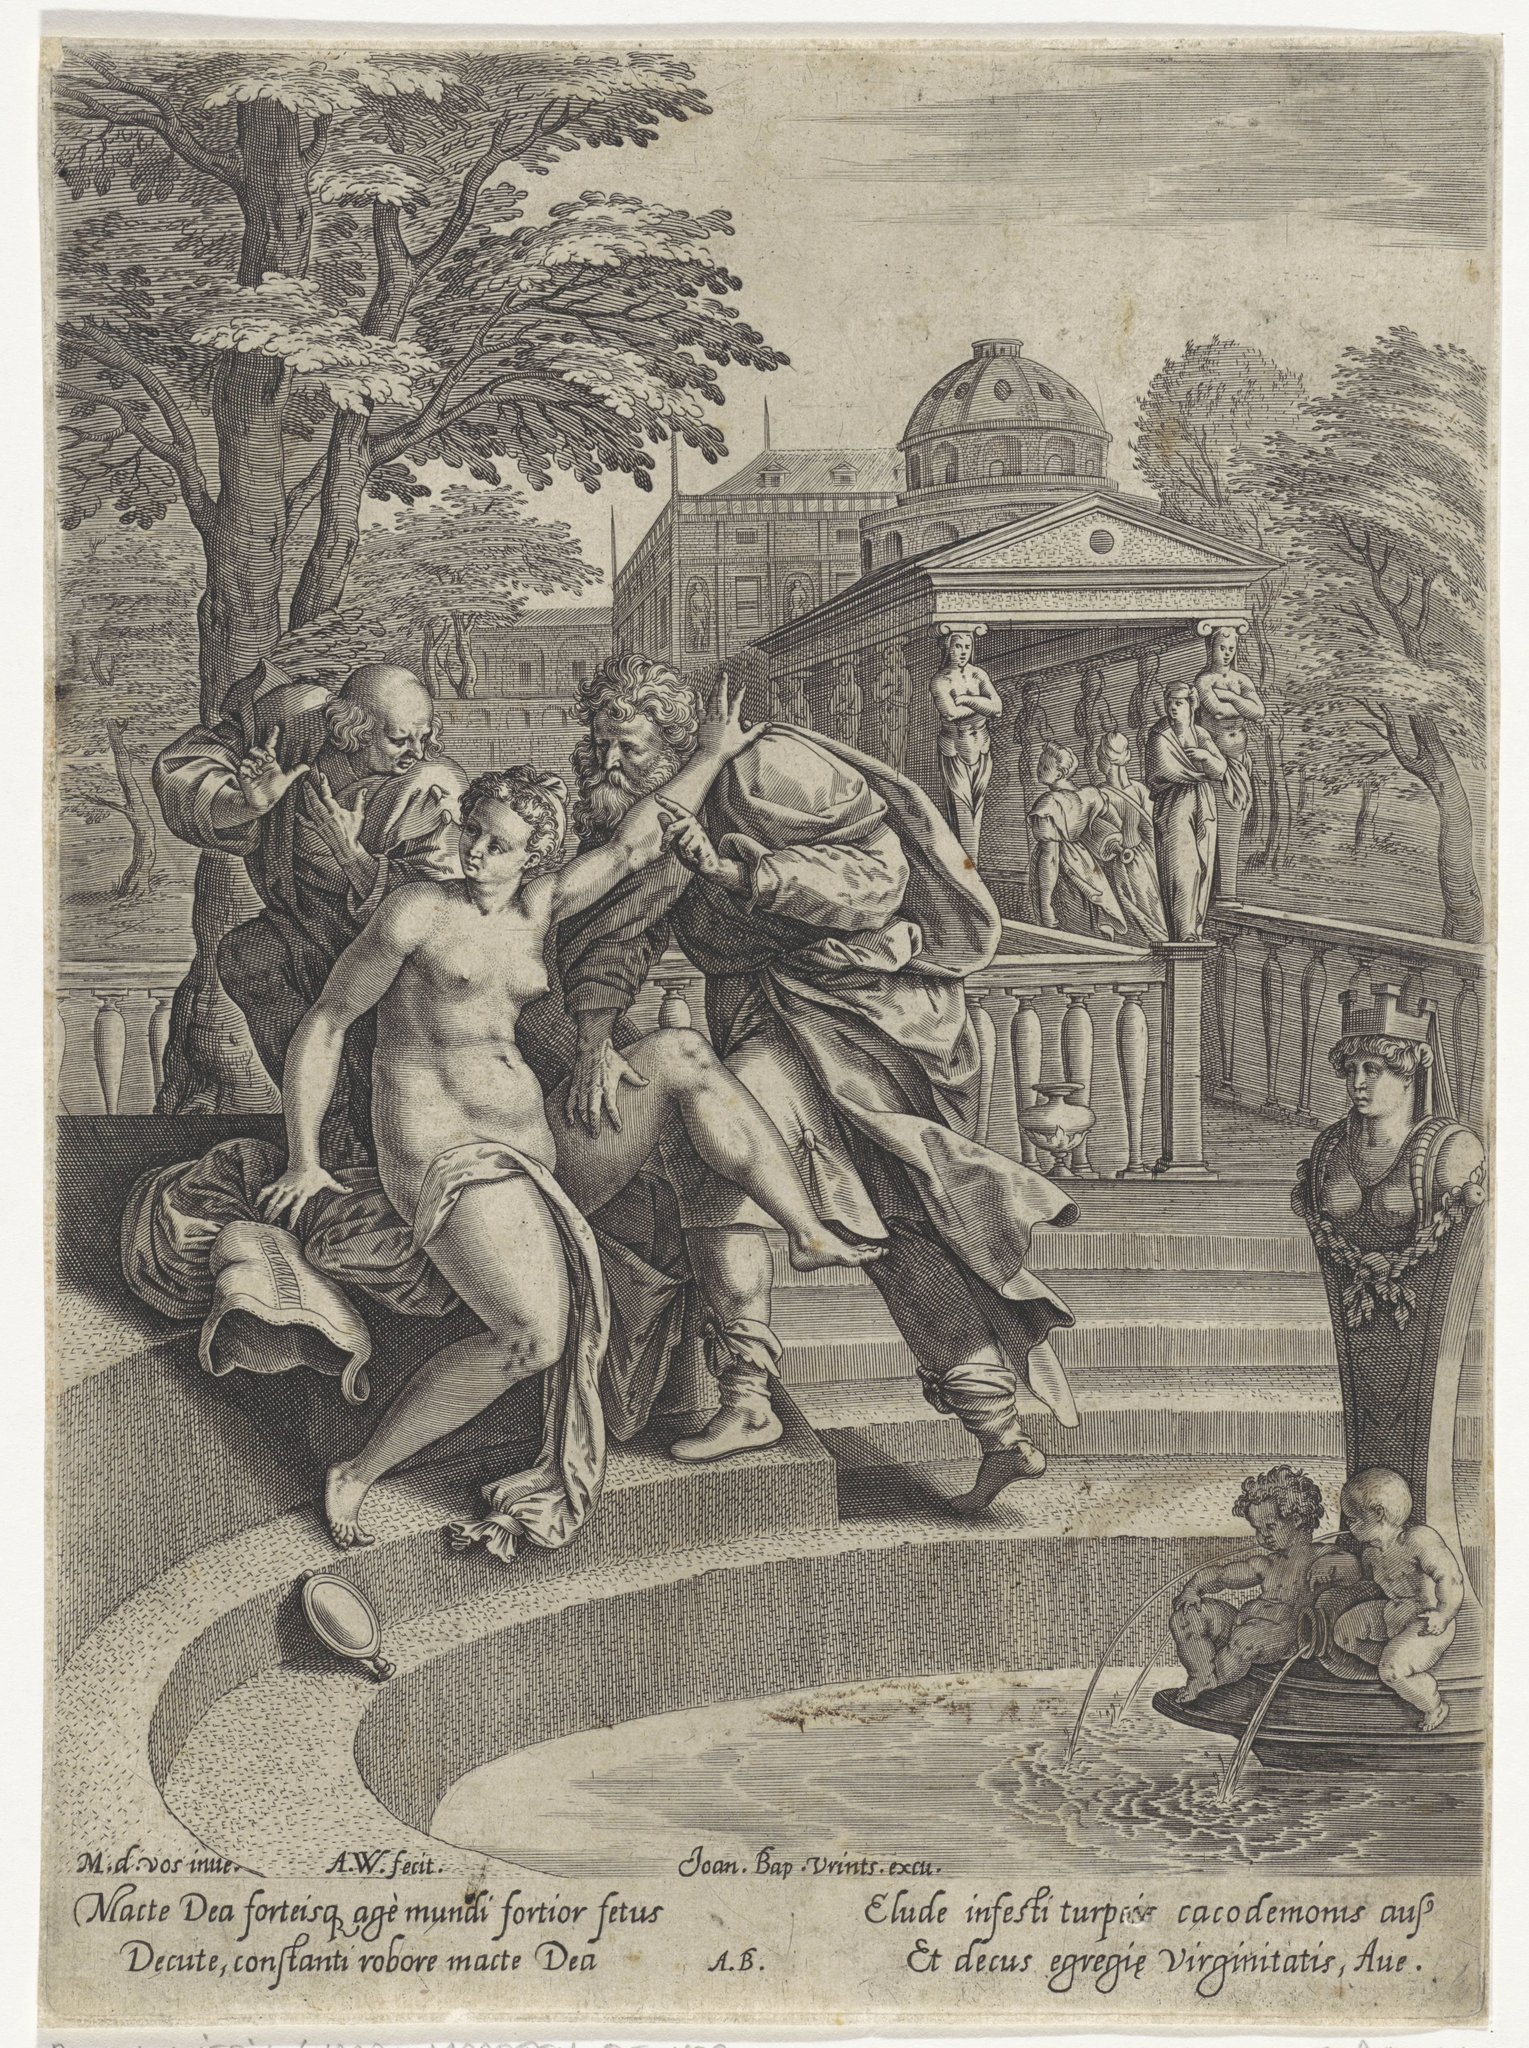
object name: print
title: Susanna en de ouderlingen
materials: paper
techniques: engraving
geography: antwerp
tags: the elders making advances towards susanna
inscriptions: collector's mark: Lugt 240, number: ‘38 - 6’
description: Susanna wordt bij het baden in een fontein door twee ouderlingen betast. Ze probeert hen af te weren. Haar twee bedienden lopen op de achtergrond in de tuin door een galerij. In de marge een vierregelig onderschrift, in twee kolommen, in het Latijn.